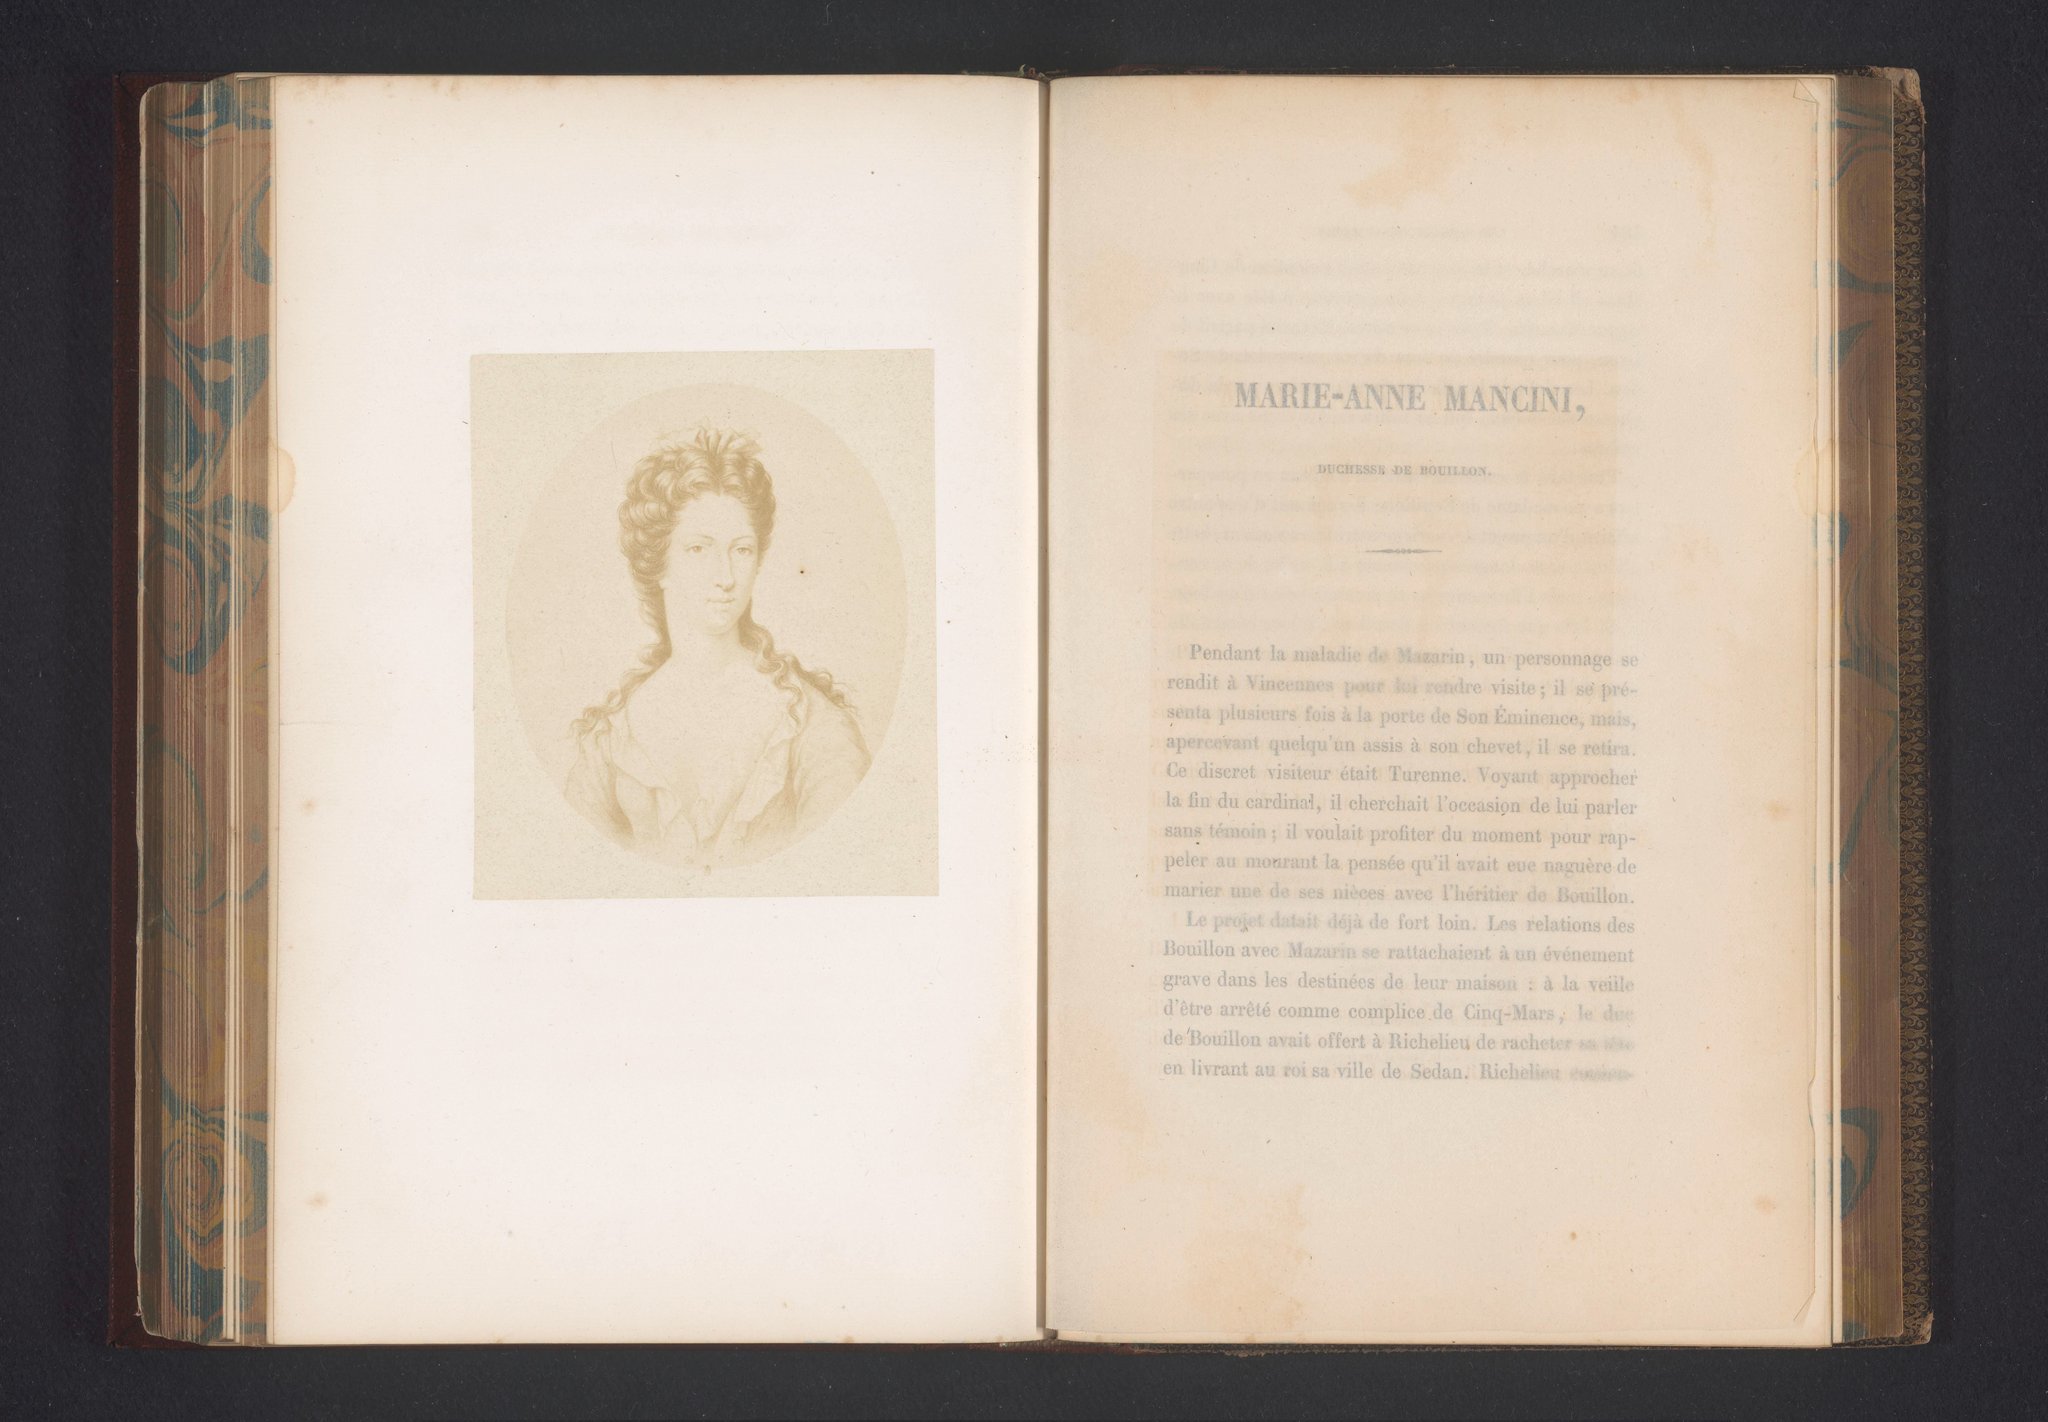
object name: photograph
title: Fotoreproductie van een portret van Marie Anne Mancini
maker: bertsch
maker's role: fotograaf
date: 1850-1858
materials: photographic support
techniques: salted paper print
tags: family of a ruler, and court